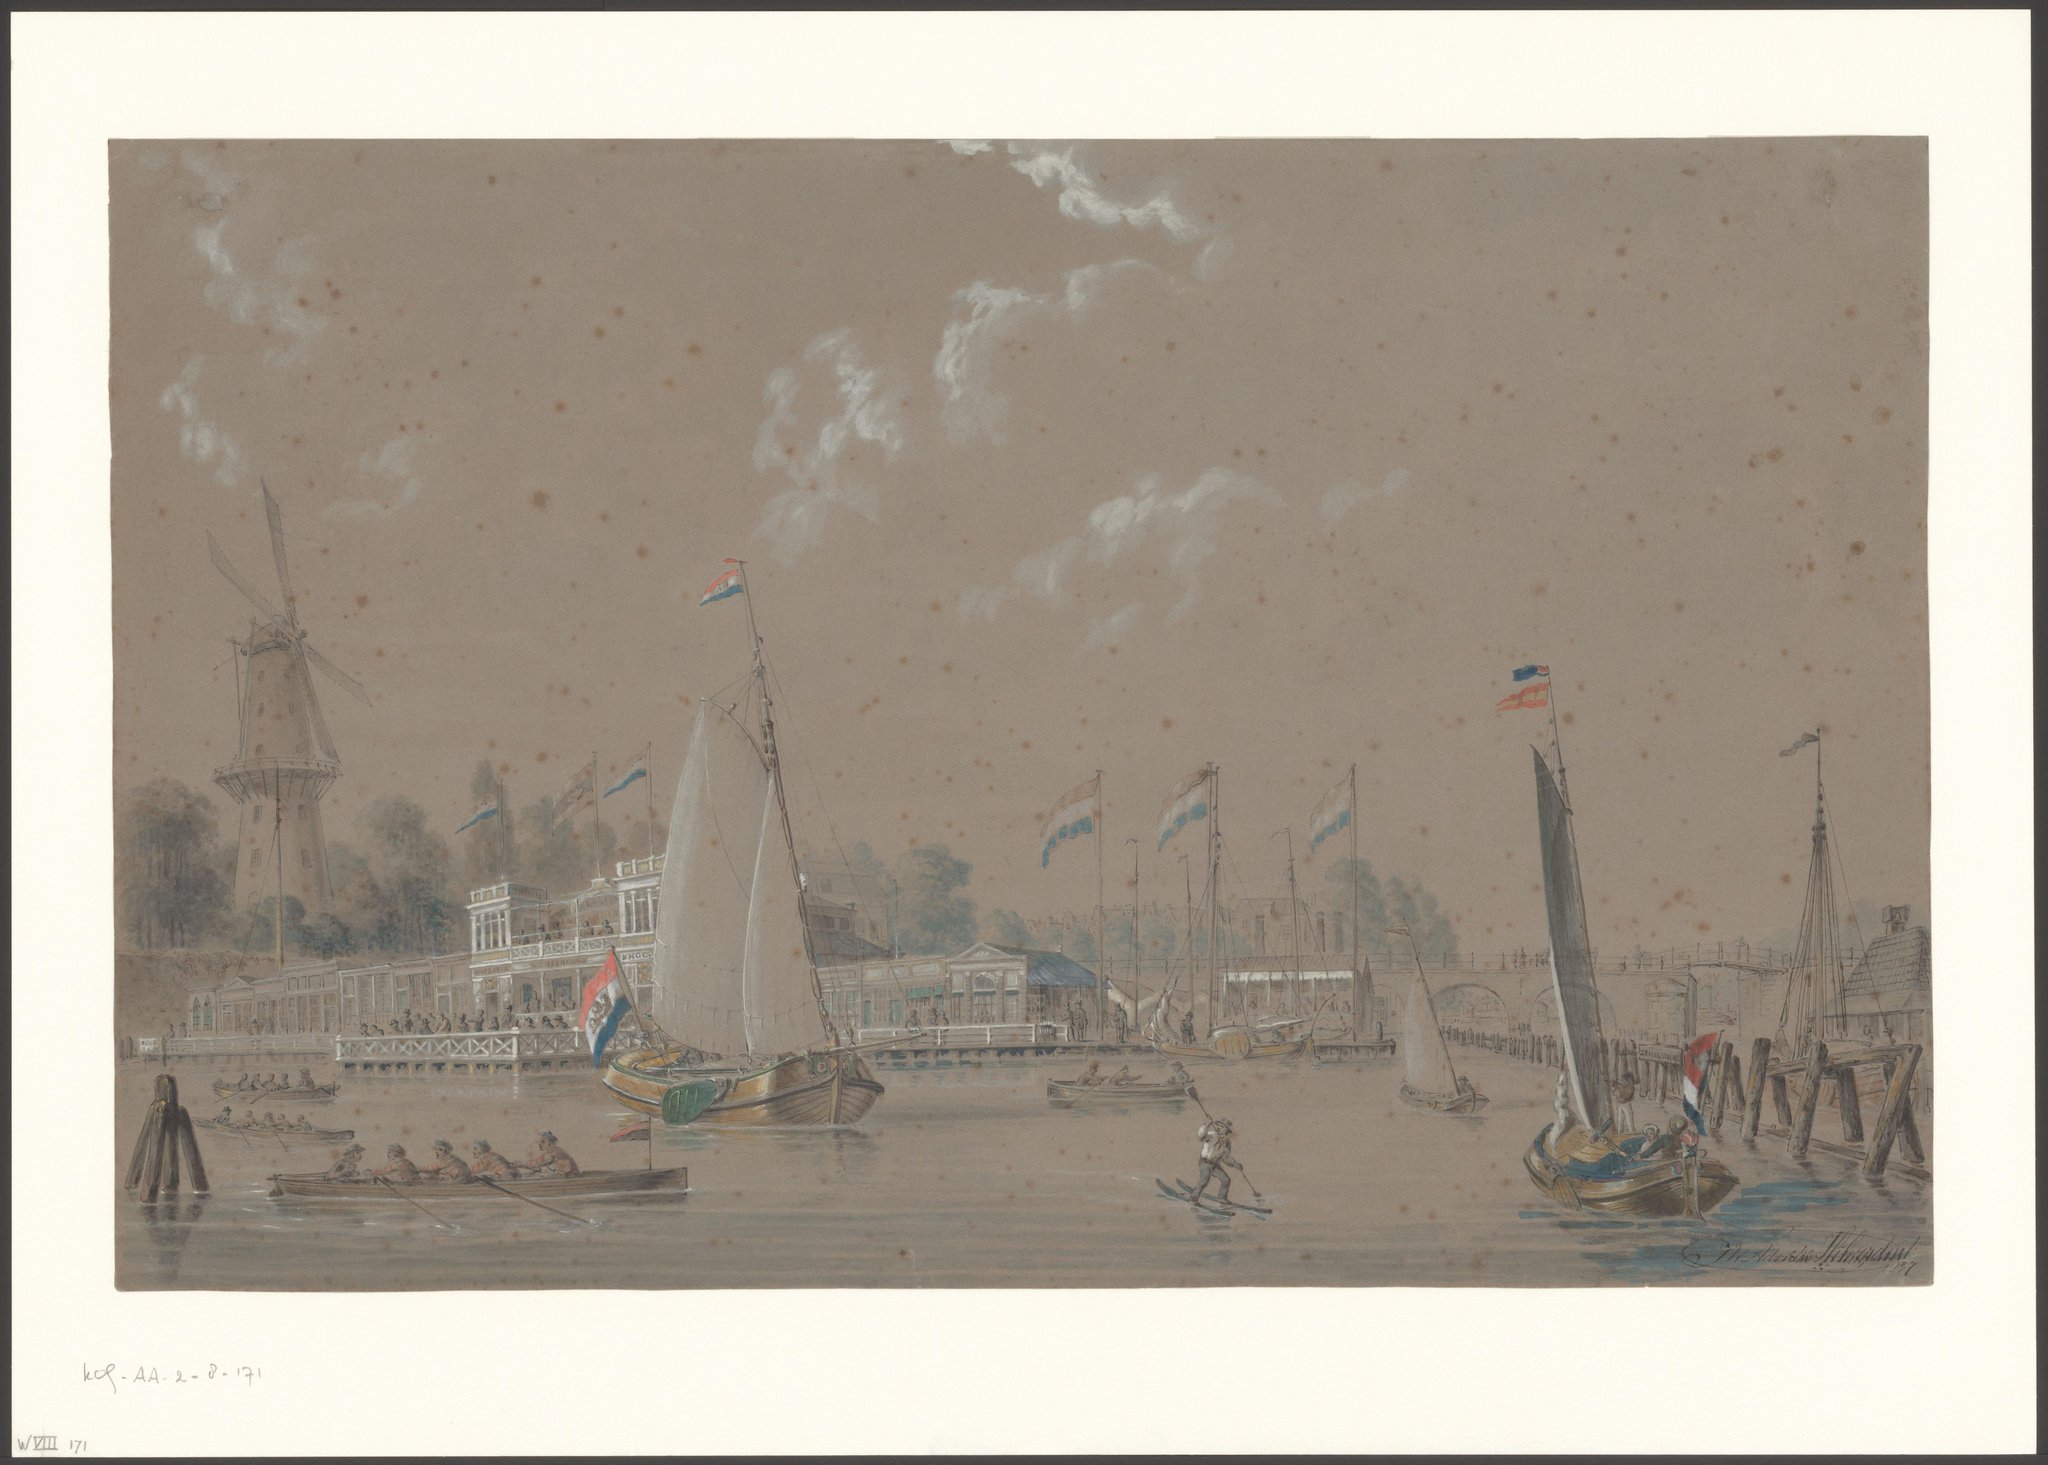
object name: drawing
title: Gezicht op de Amstel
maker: jacobus wilhelmus adrianus hilverdink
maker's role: print maker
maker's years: 1809-1864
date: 1837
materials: paint, ink, paper, watercolor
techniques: brush, pen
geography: amsterdam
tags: sailing-ship, sailing-boat, city-view in general; 'veduta', river, windmill in landscape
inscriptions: signature and date: ‘JWAdrianusHilverdink / 1837’, collector's mark: Lugt 800a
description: Tekening binnen de Atlas Van Eck ingedeeld op wijknummer 8.